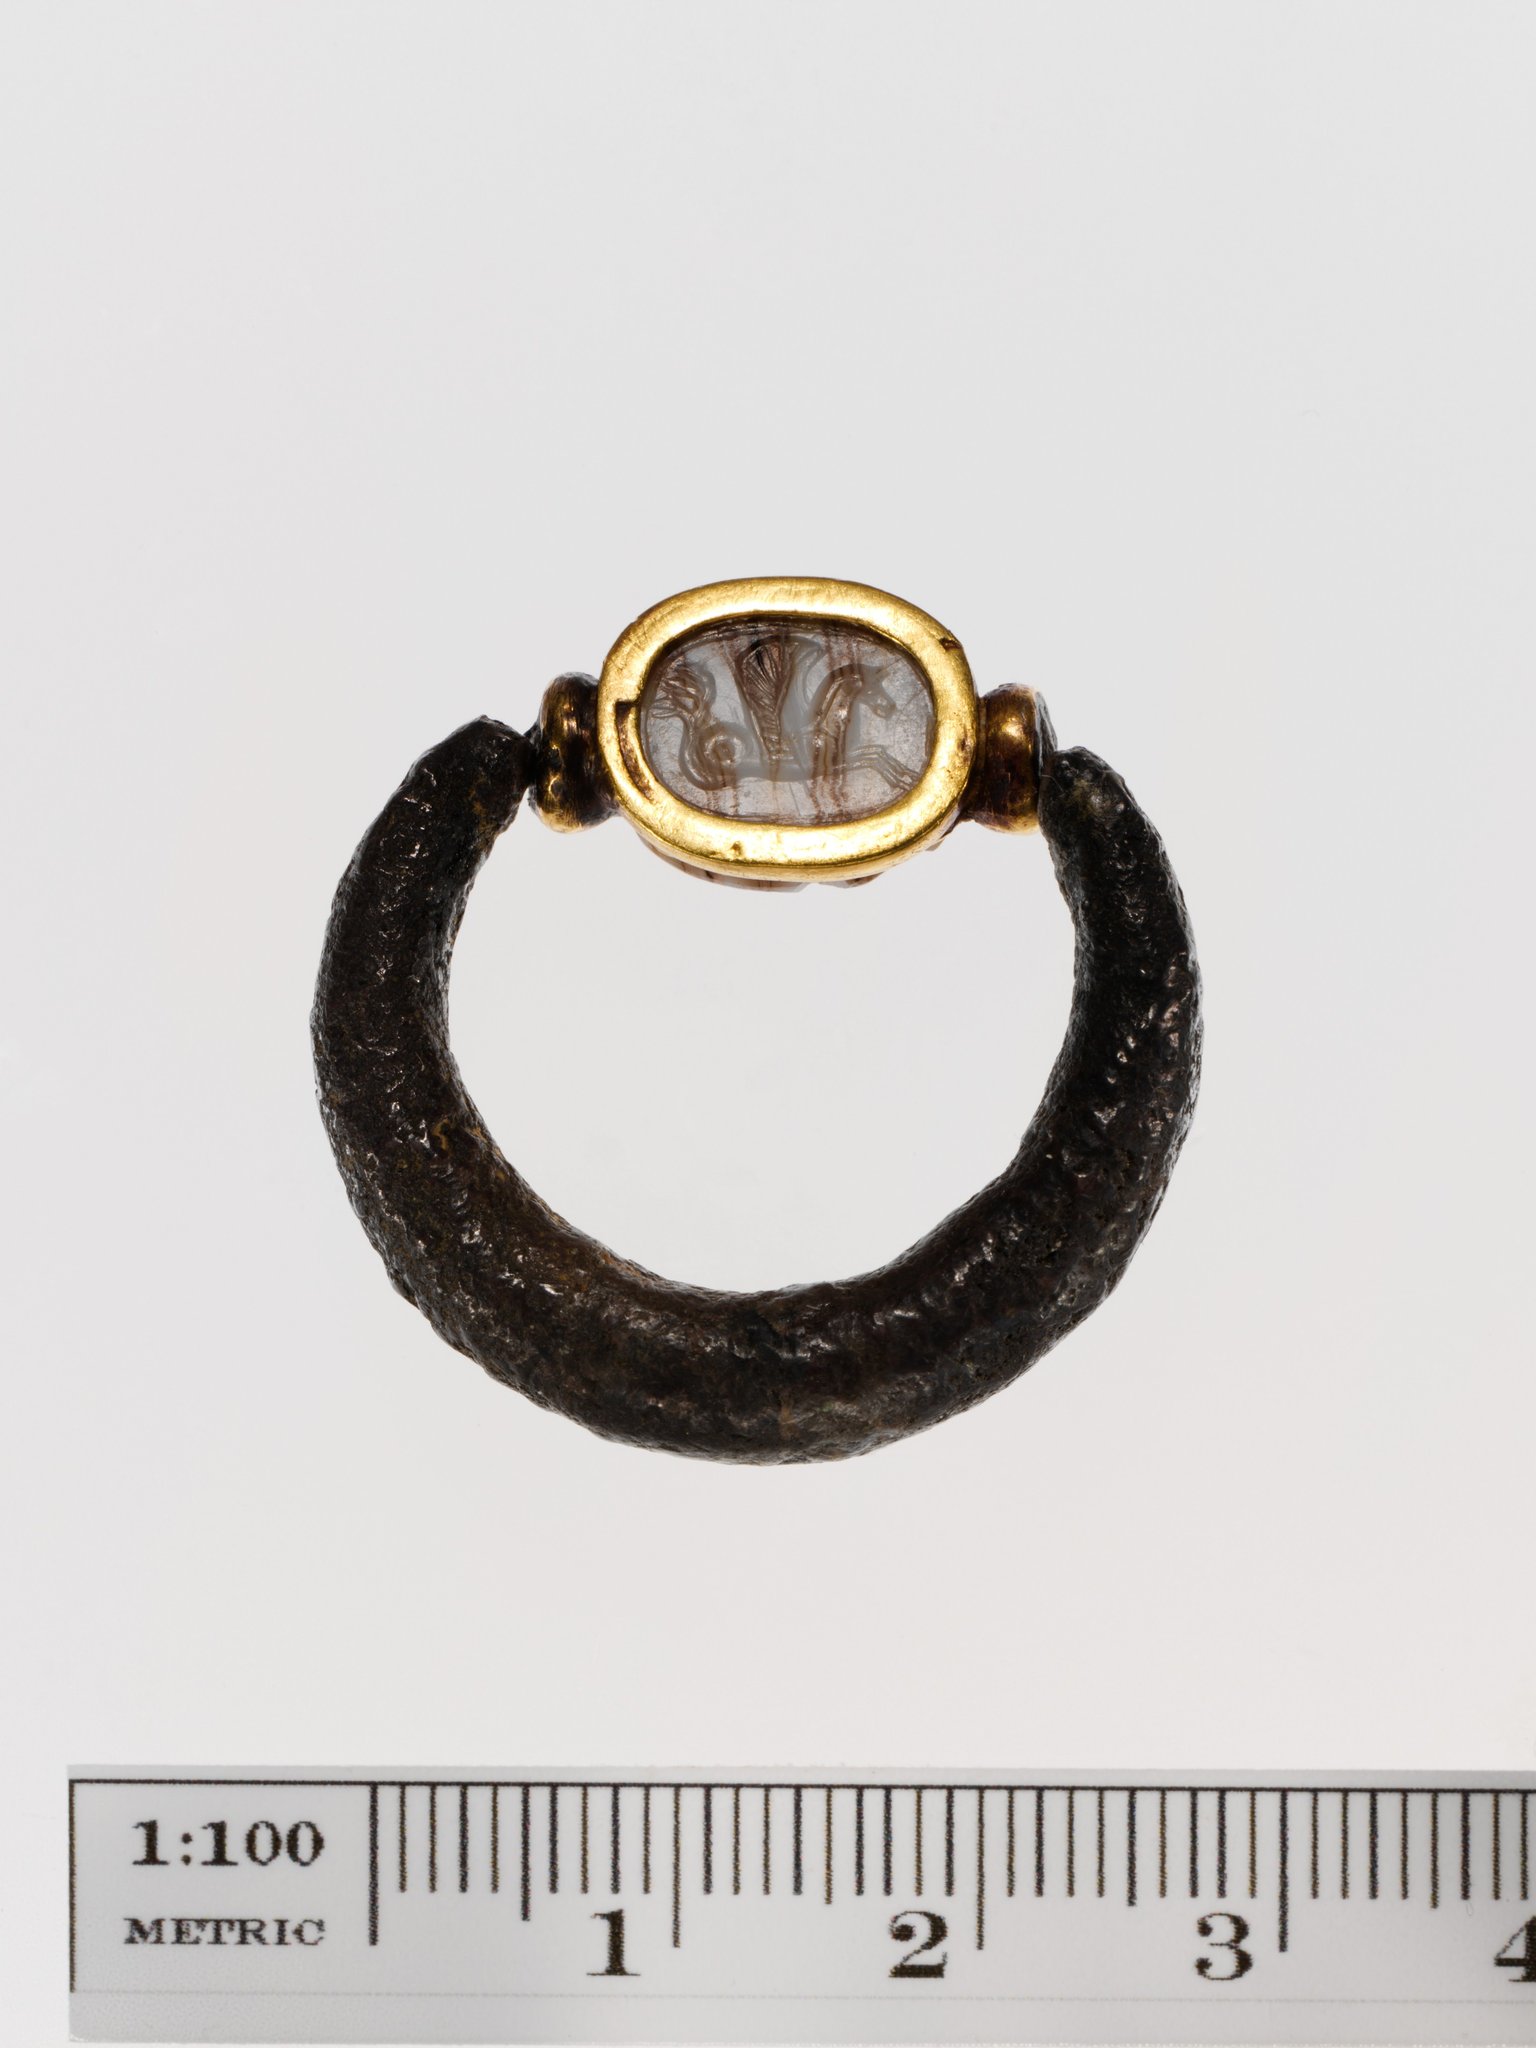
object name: scarab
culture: cypriot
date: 3900 BCE-100 CE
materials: stone, gold, silver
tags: mythical creatures